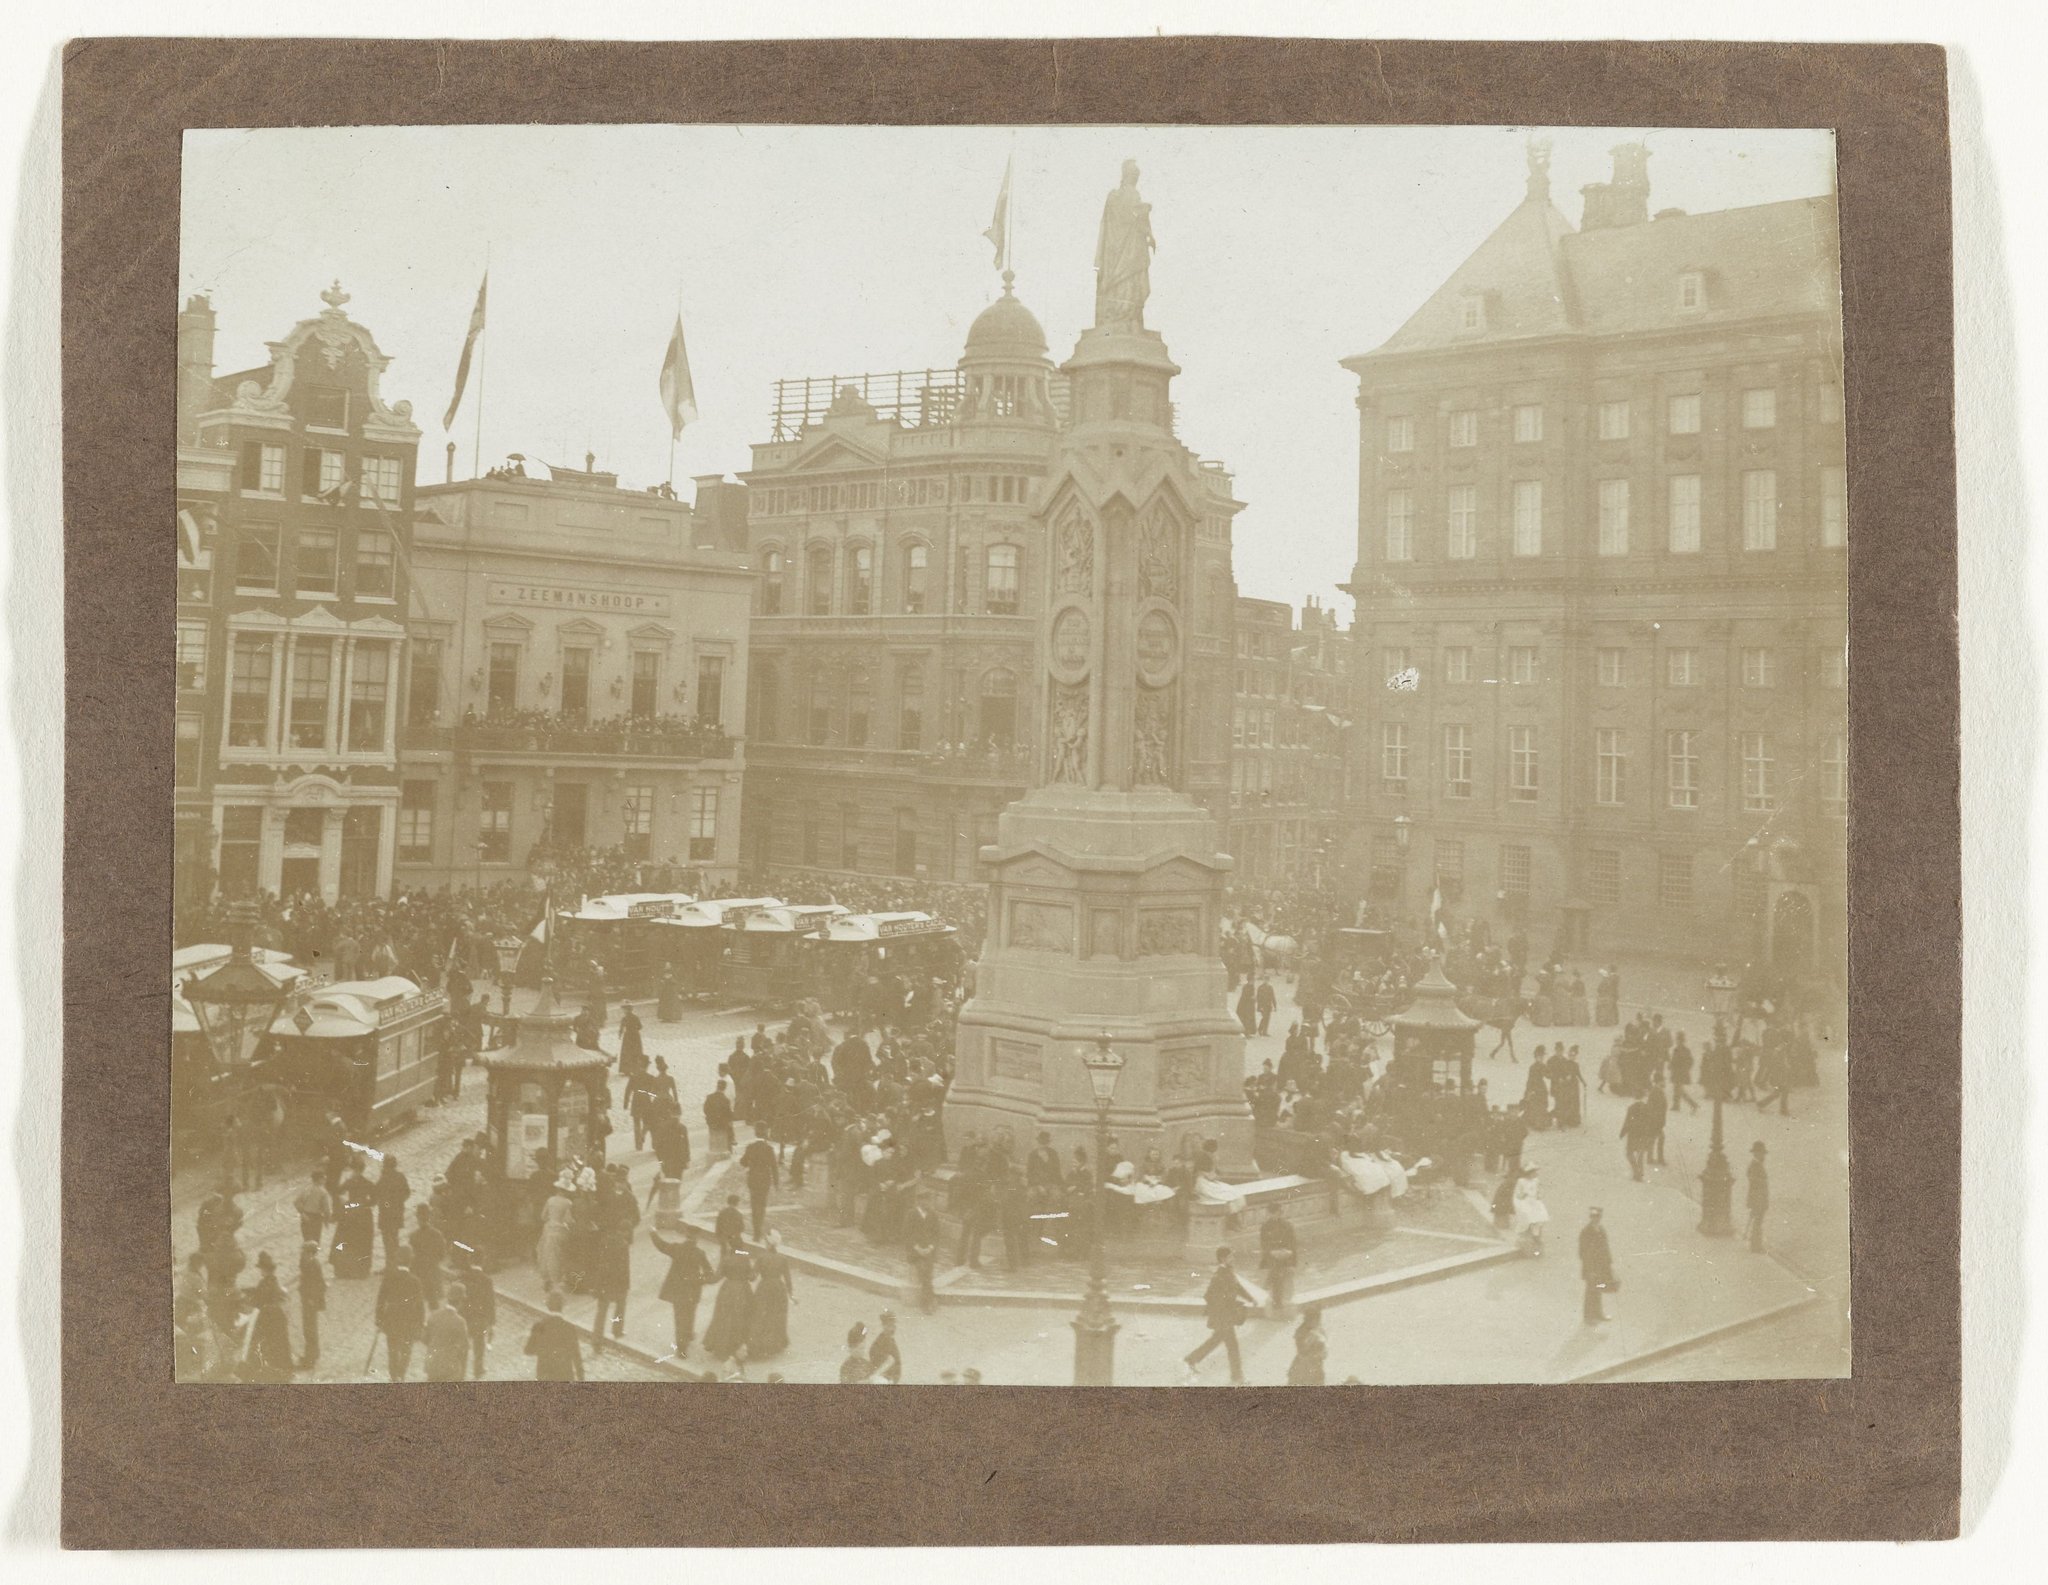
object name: photograph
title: Monument de Eendracht, genoemd Naatje op de Dam, Amsterdam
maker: Anonymous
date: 1880-1914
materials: paper, cardboard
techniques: collodion silver print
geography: amsterdam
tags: square, place, circus, etc., diligence, omnibus, horse-tram, monument, statue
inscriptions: inscription: ‘Wed. Wm. Holst/ Amsterdam/ Prijslijst A/ van/ Leonar Papieren en/ Leonar Verpakte/ Chemicaliën/ voor/ Amateur Gebruik.’